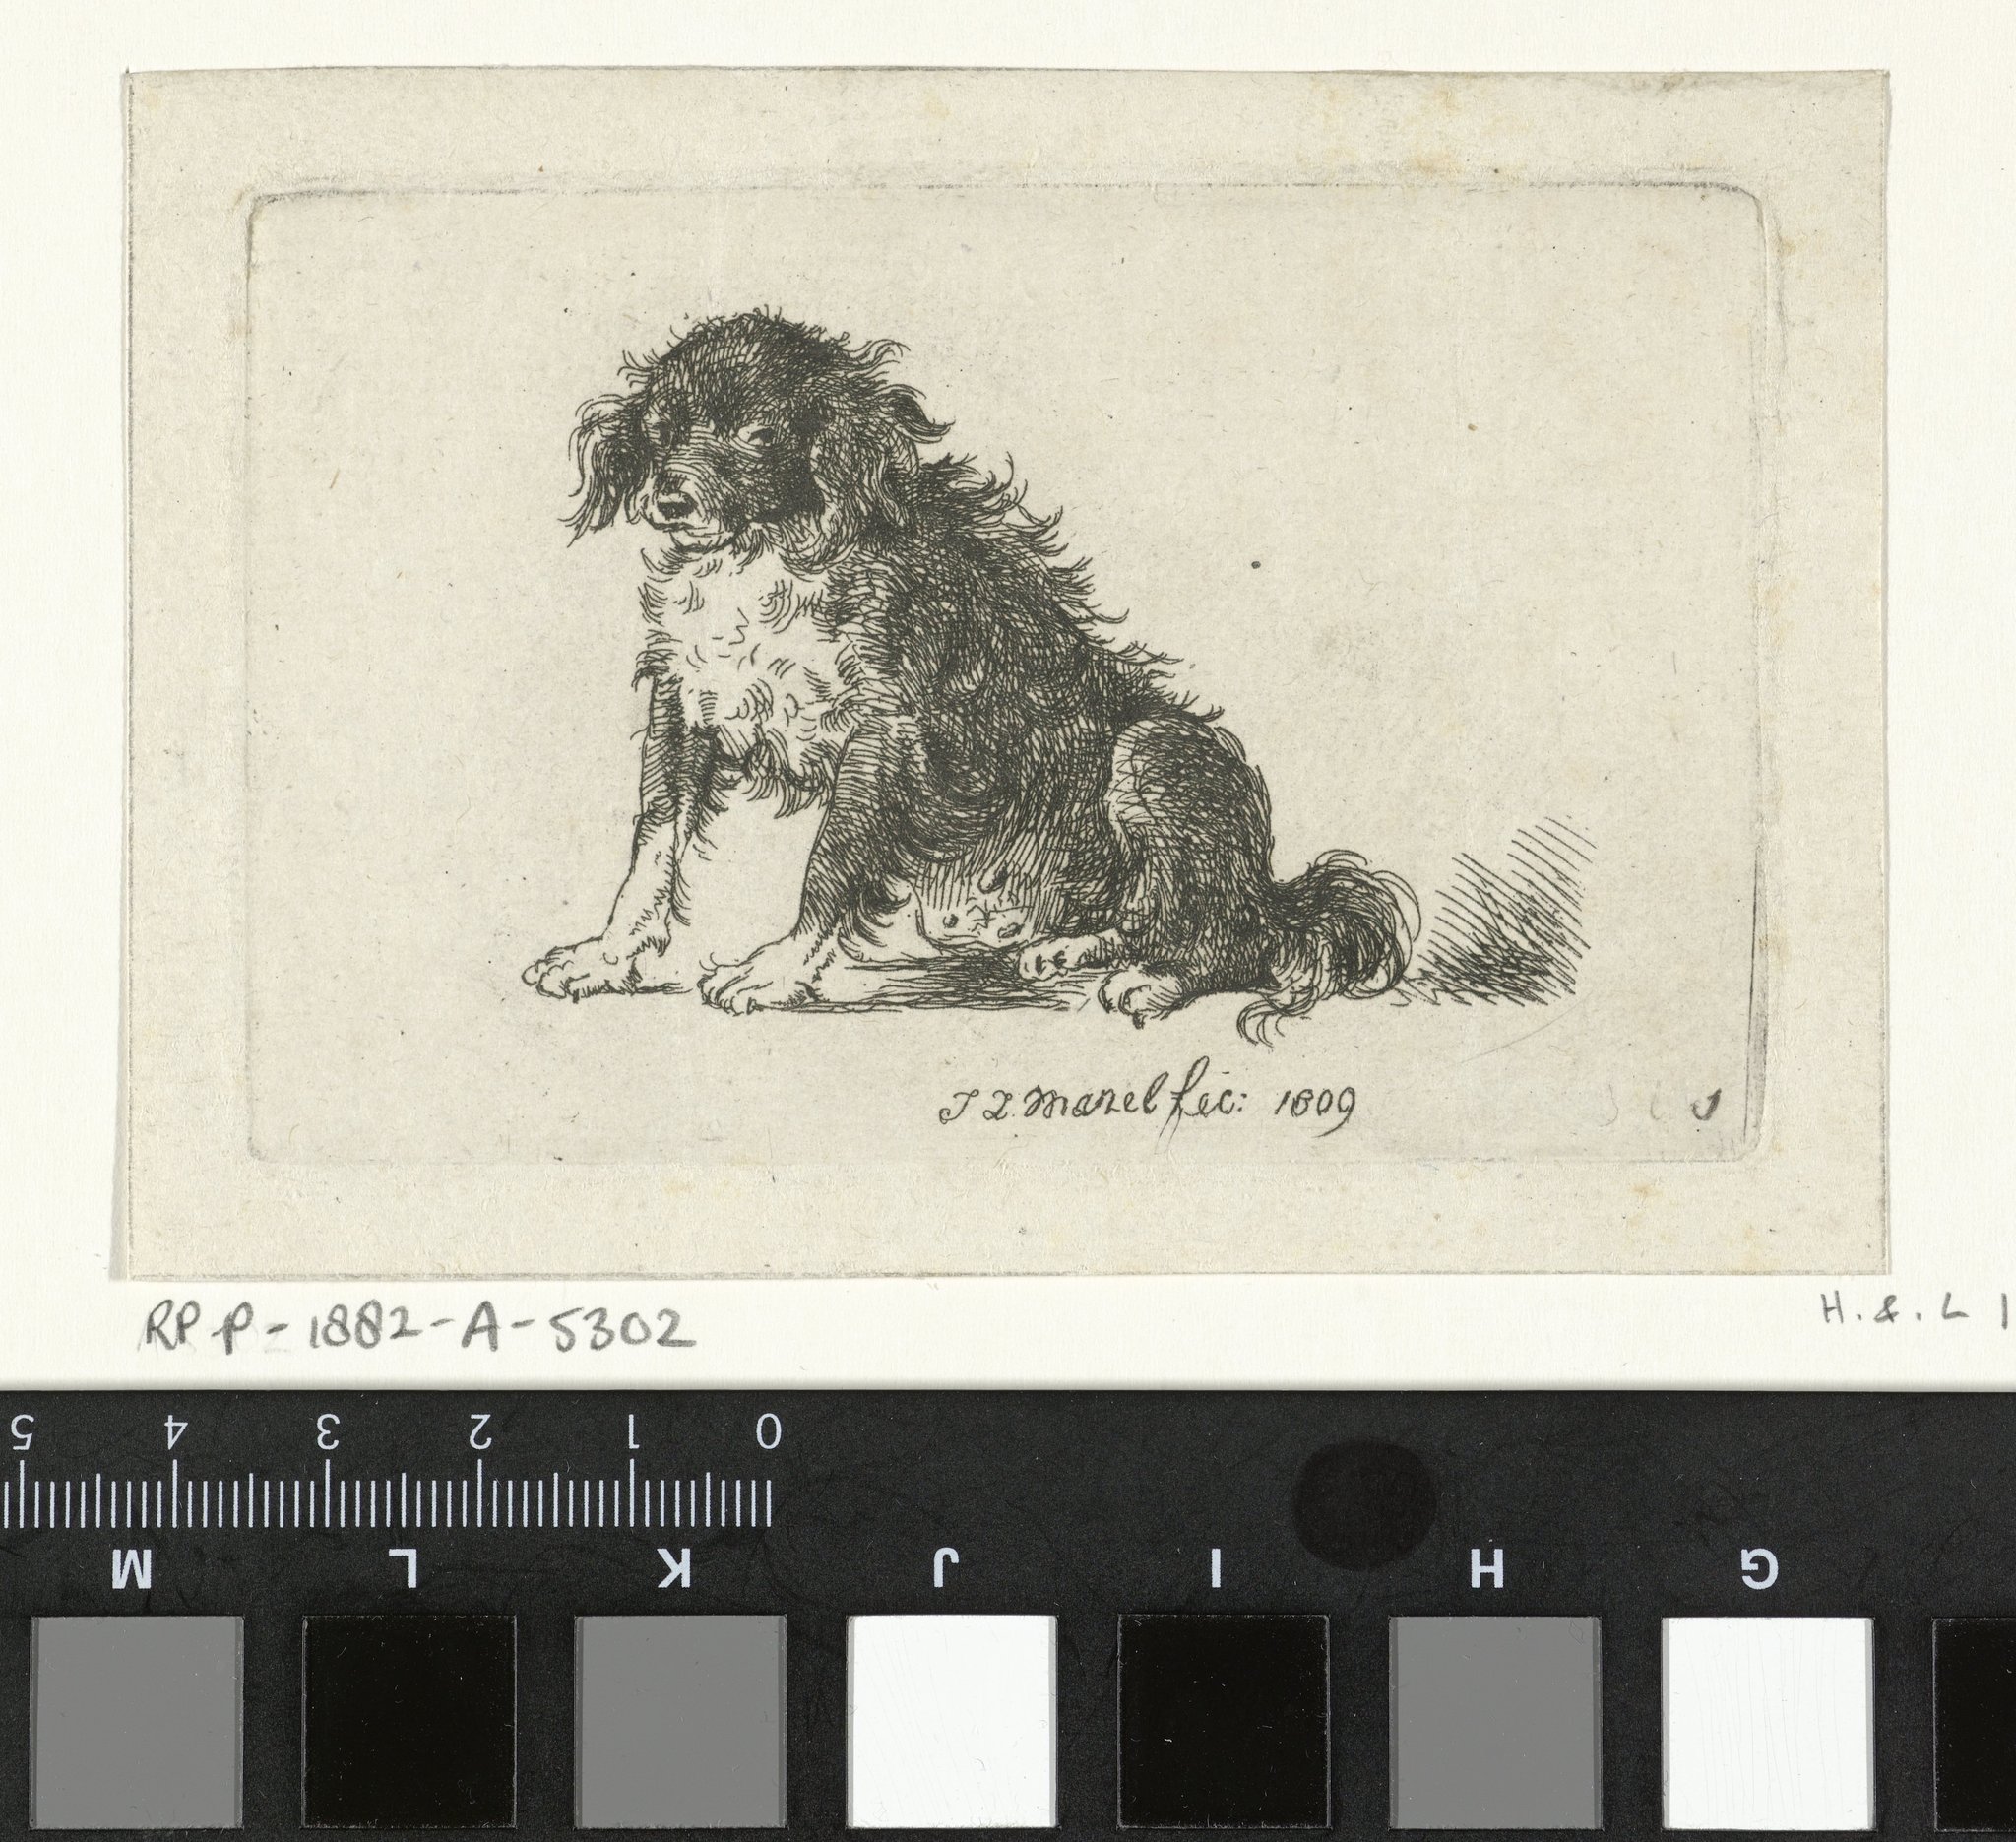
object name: print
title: Zittende hond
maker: jean zacherie mazel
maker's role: draughtsman, print maker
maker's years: 1792-1884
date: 1809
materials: paper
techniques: etching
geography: netherlands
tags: dog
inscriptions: collector's mark: Lugt 2228